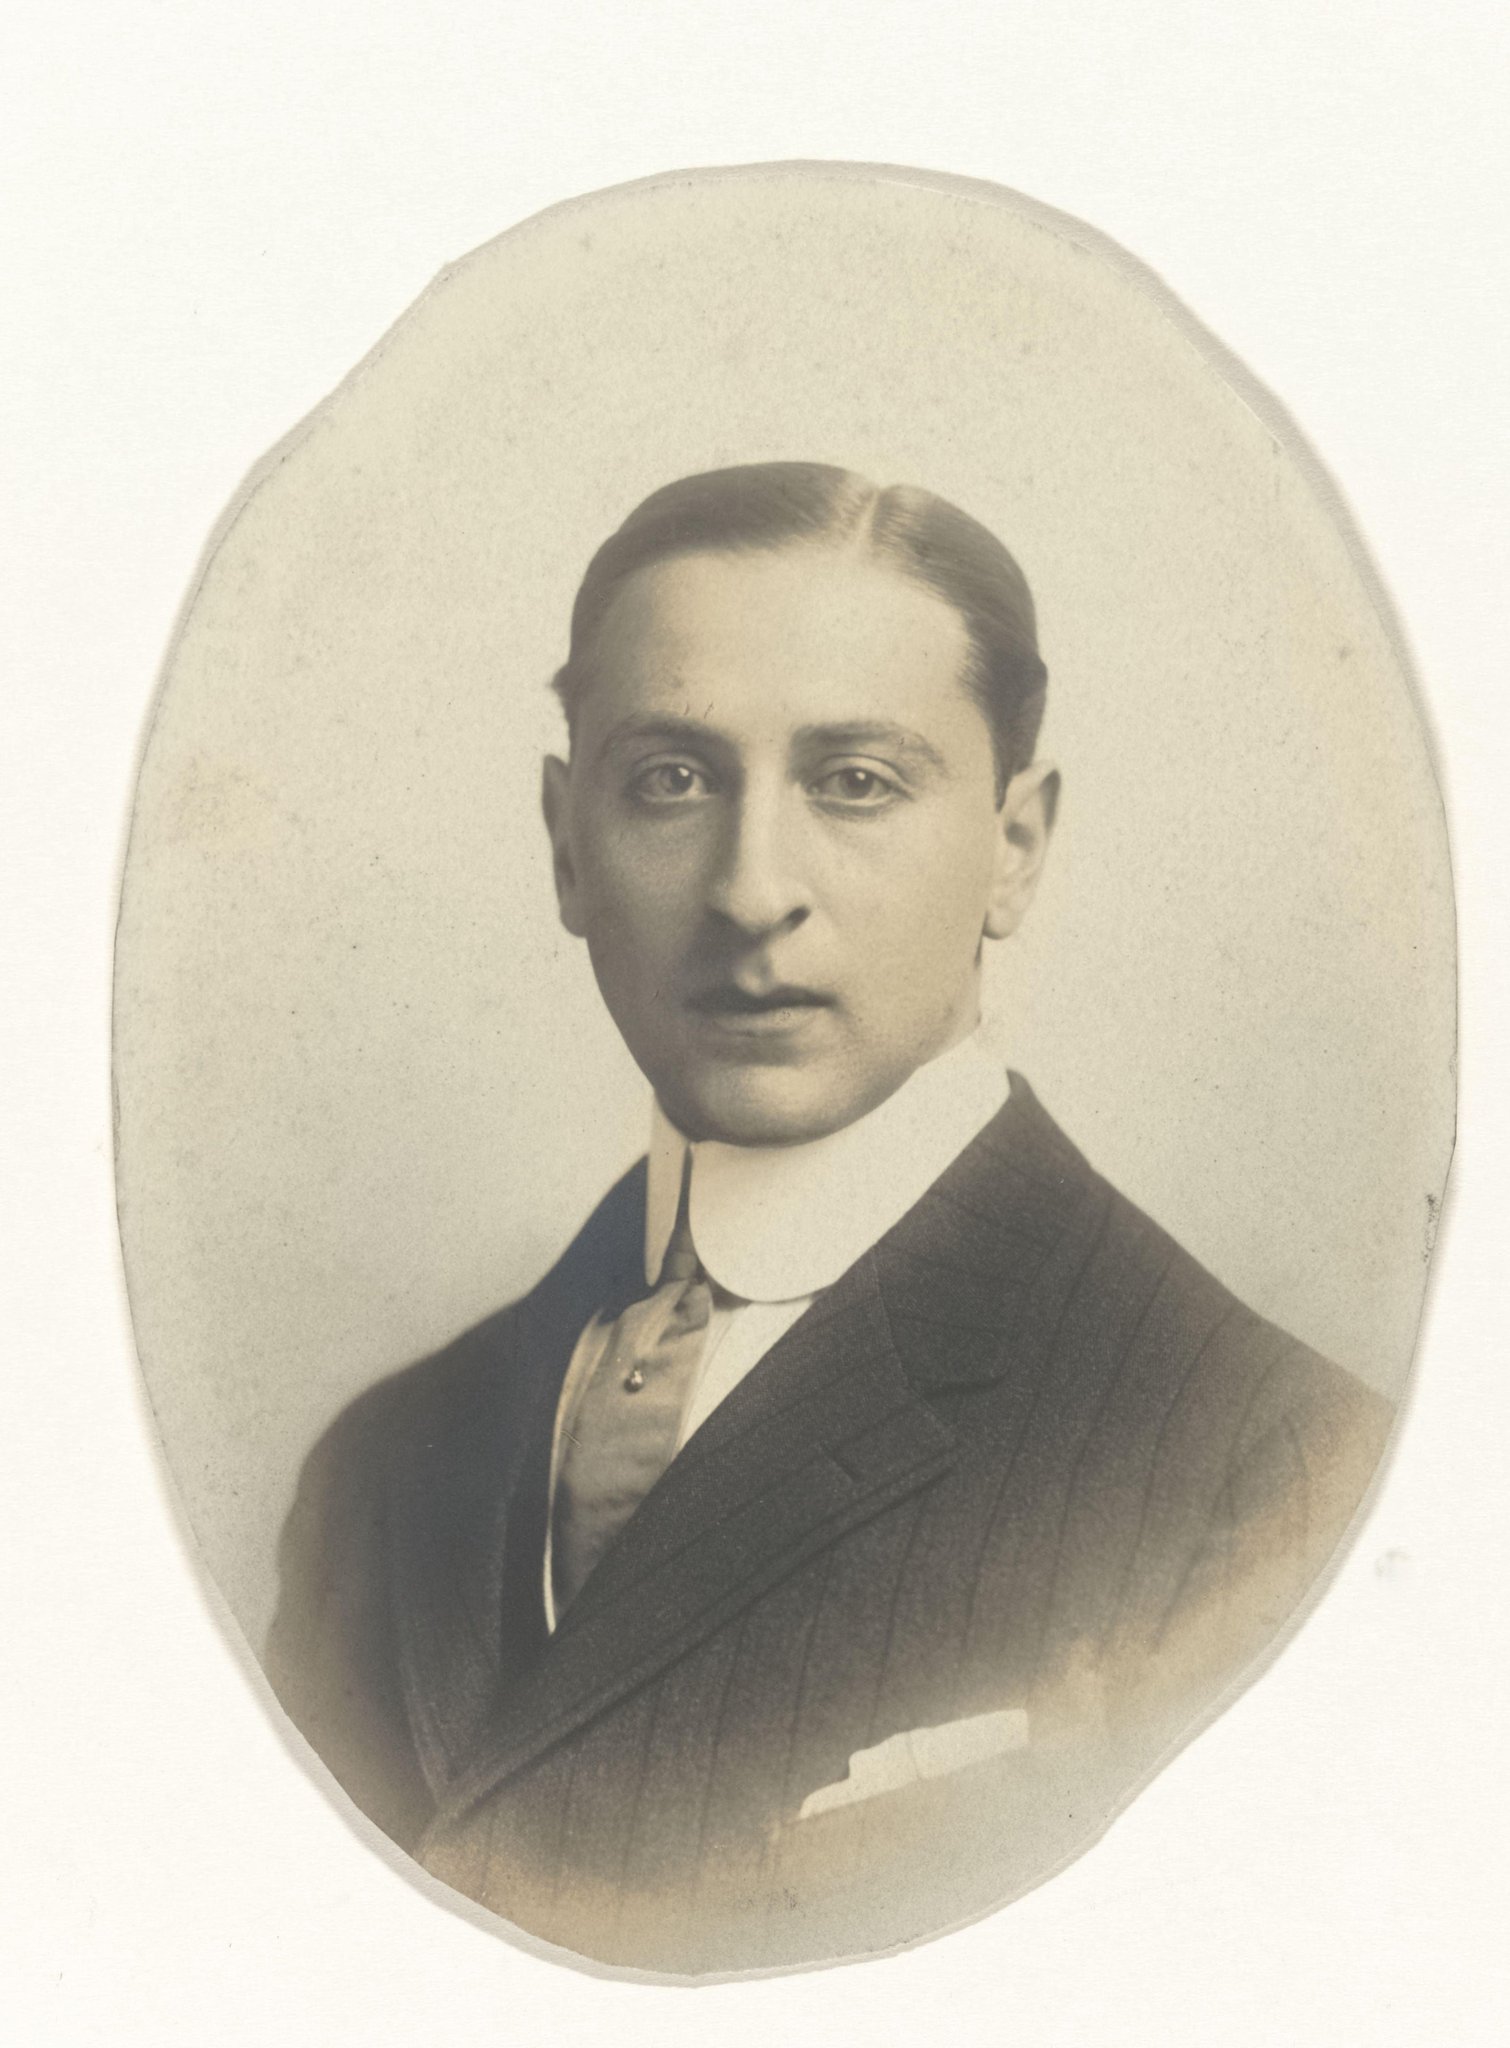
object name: photograph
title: Portret van Arthur Moos, 1903-1922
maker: Anonymous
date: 1903-1922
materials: photographic support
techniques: gelatin silver print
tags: arthur moos